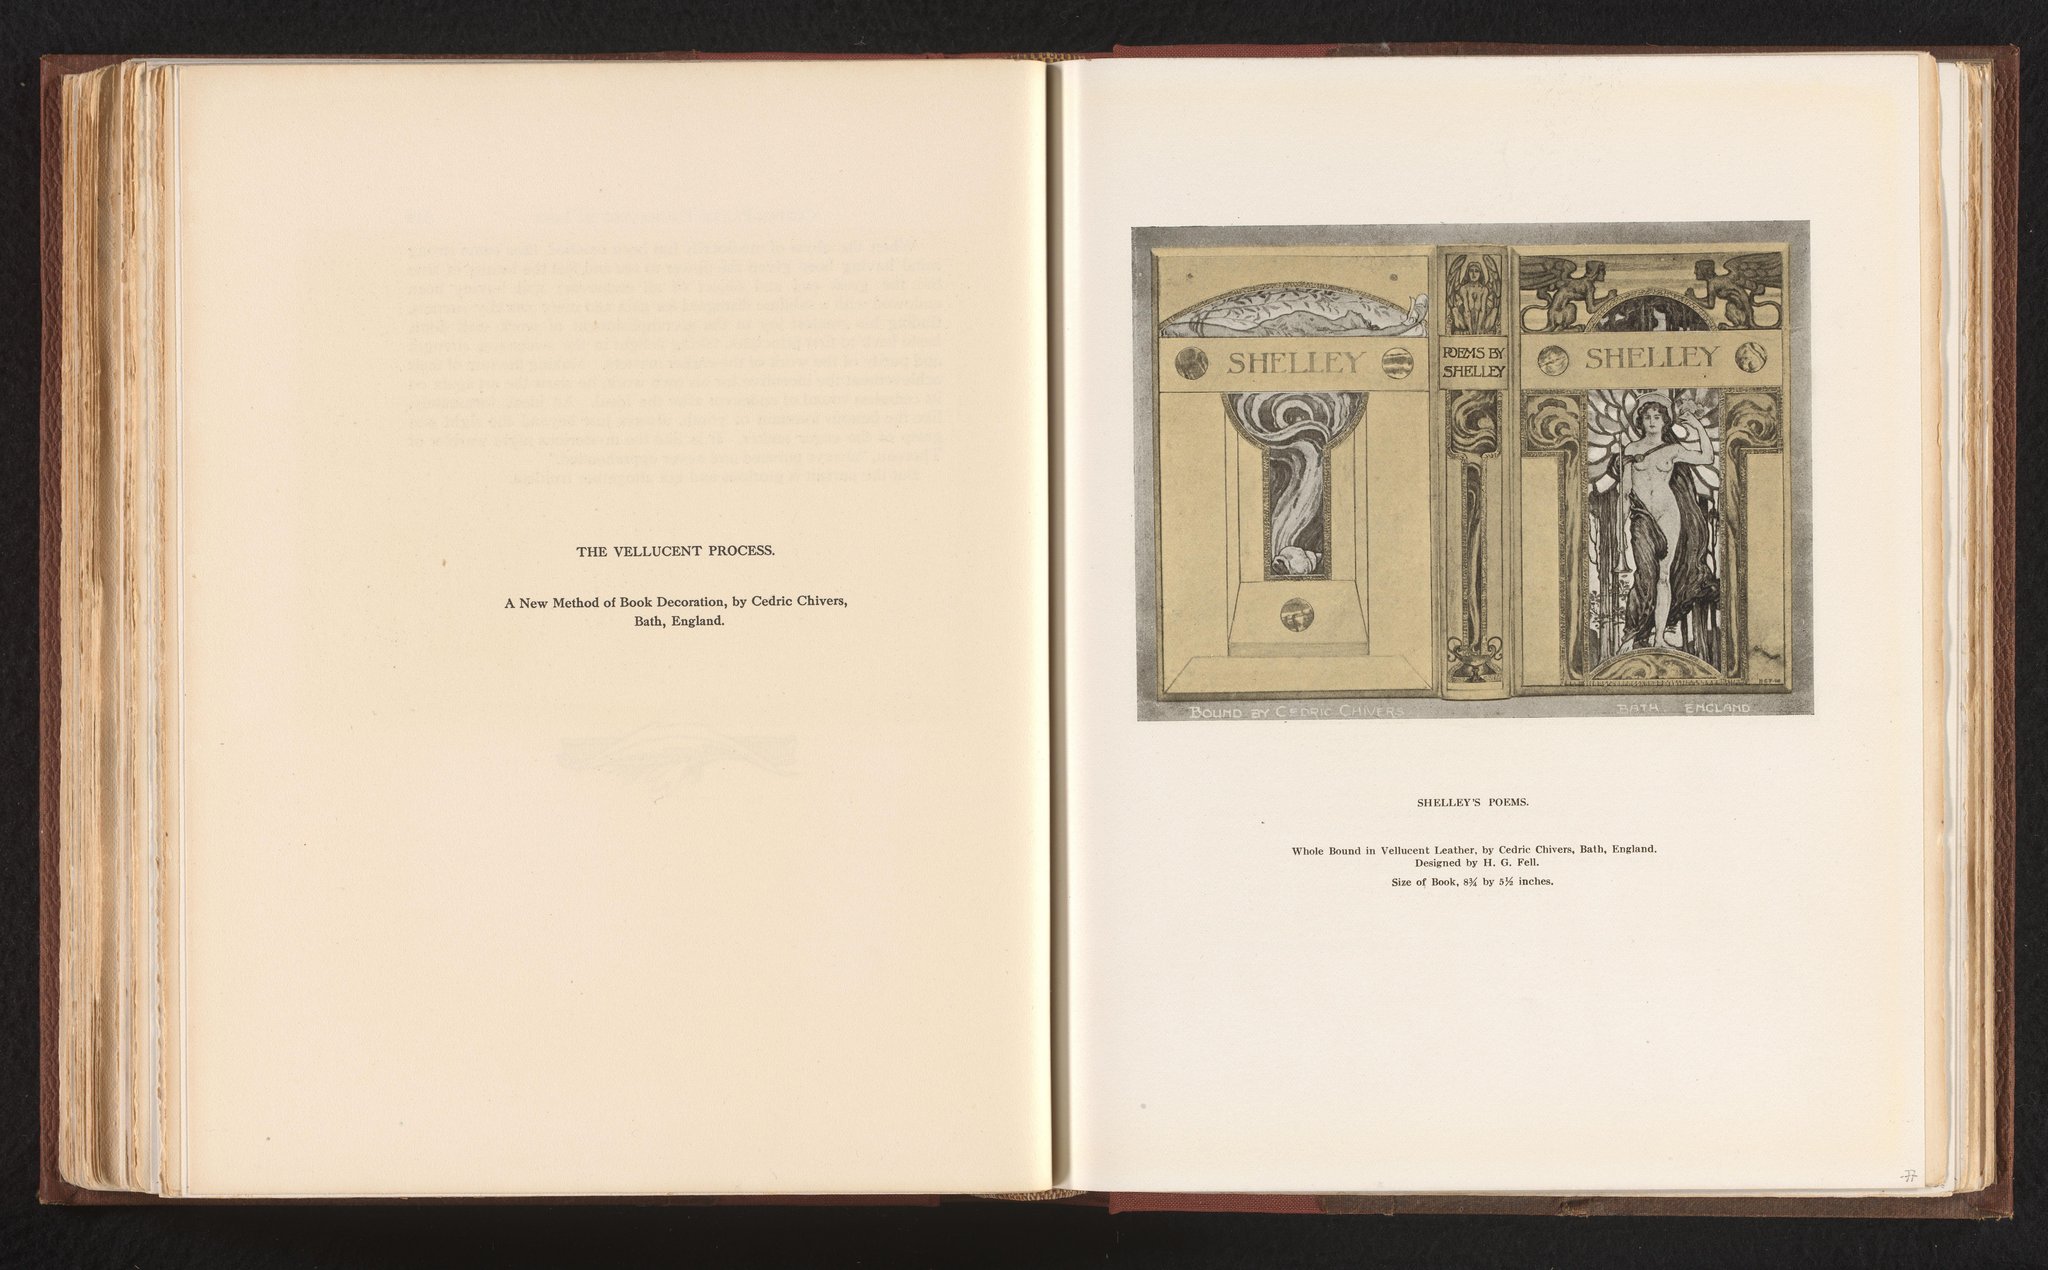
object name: photomechanical print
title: Shelley's poems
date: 1904-1909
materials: paper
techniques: color autotype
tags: book-cover, binding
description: Prent op tweede ongenummerde pagina na pagina 319.